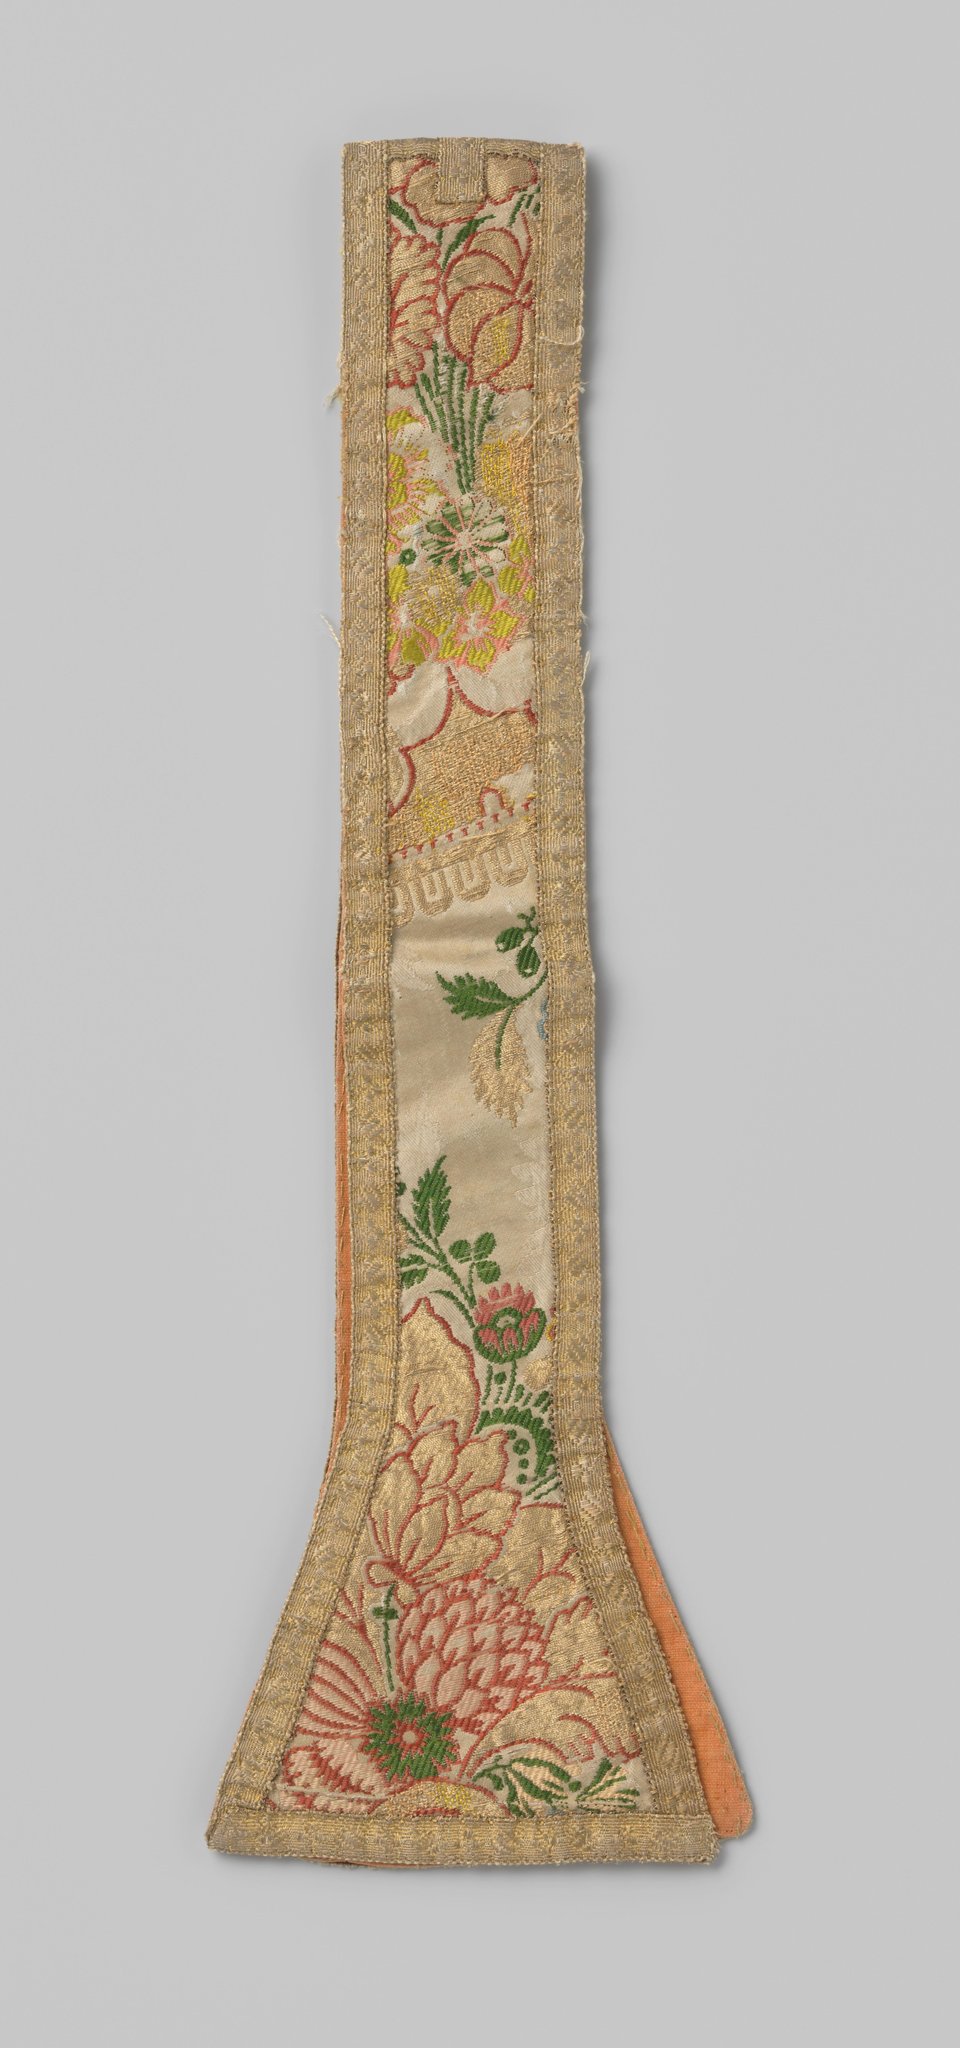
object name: maniple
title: Manipel van goudbrokaat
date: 1700-1725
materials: textile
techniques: brocade, embroidered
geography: france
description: Manipel van goudbrocaat. Bij de manipel horen twee manipels met invnrs. BK-1972-1-G en BK-1972-1-H. De manipels horen bij negen kerkelijke weefsels met borduurwerk met invnrs. BK-1972-1-A t/m BK-1972-1-I en een niet bijbehorende beurs met invnr. BK-1972-1-J.